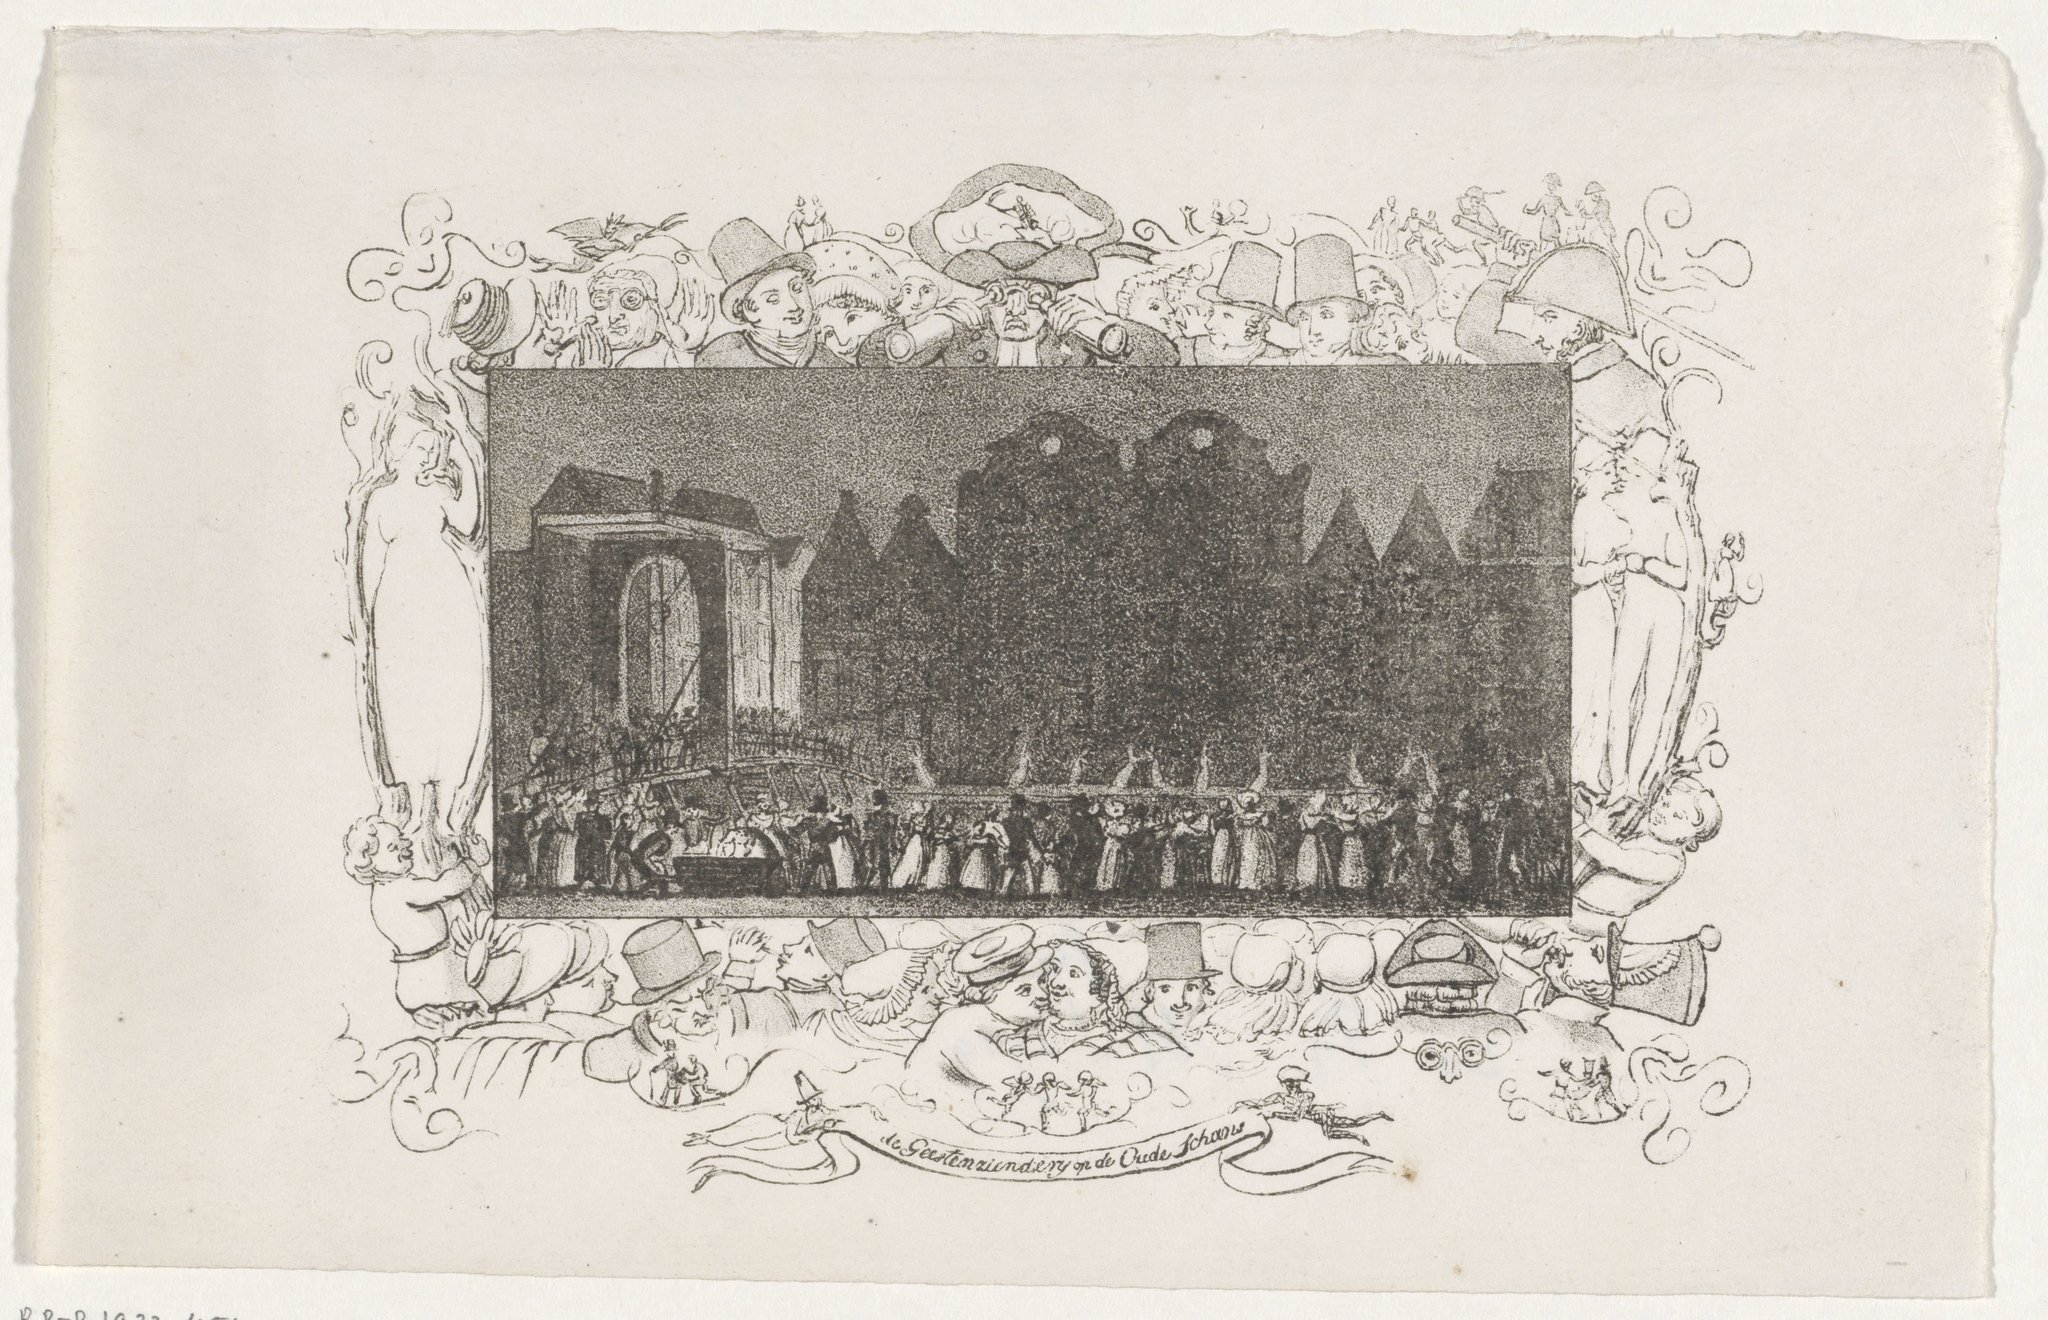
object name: print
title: de Geestenzienderij op de Oude Schans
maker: Anonymous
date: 1833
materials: paper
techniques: lithograph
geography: netherlands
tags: materialization, appearance of spirit or ghost, student life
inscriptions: collector's mark: Lugt 2233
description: Verschijning van geesten op de Oudeschans te Amsterdam, in de avond van 8 en 9 oktober 1833. Langs de kade bewegen de spookachtige witte schimmen van vrouwen in lange gewaden. Op de voorgrond en op de brug de verzamelde toeschouwers. De 'geesten' werden voortgebracht door enige studenten met behulp van toverlantaarnplaatjes. De voorstelling binnen een randwerk met humoristische figuren: studenten, politieagent, kinderen en kussende figuren.